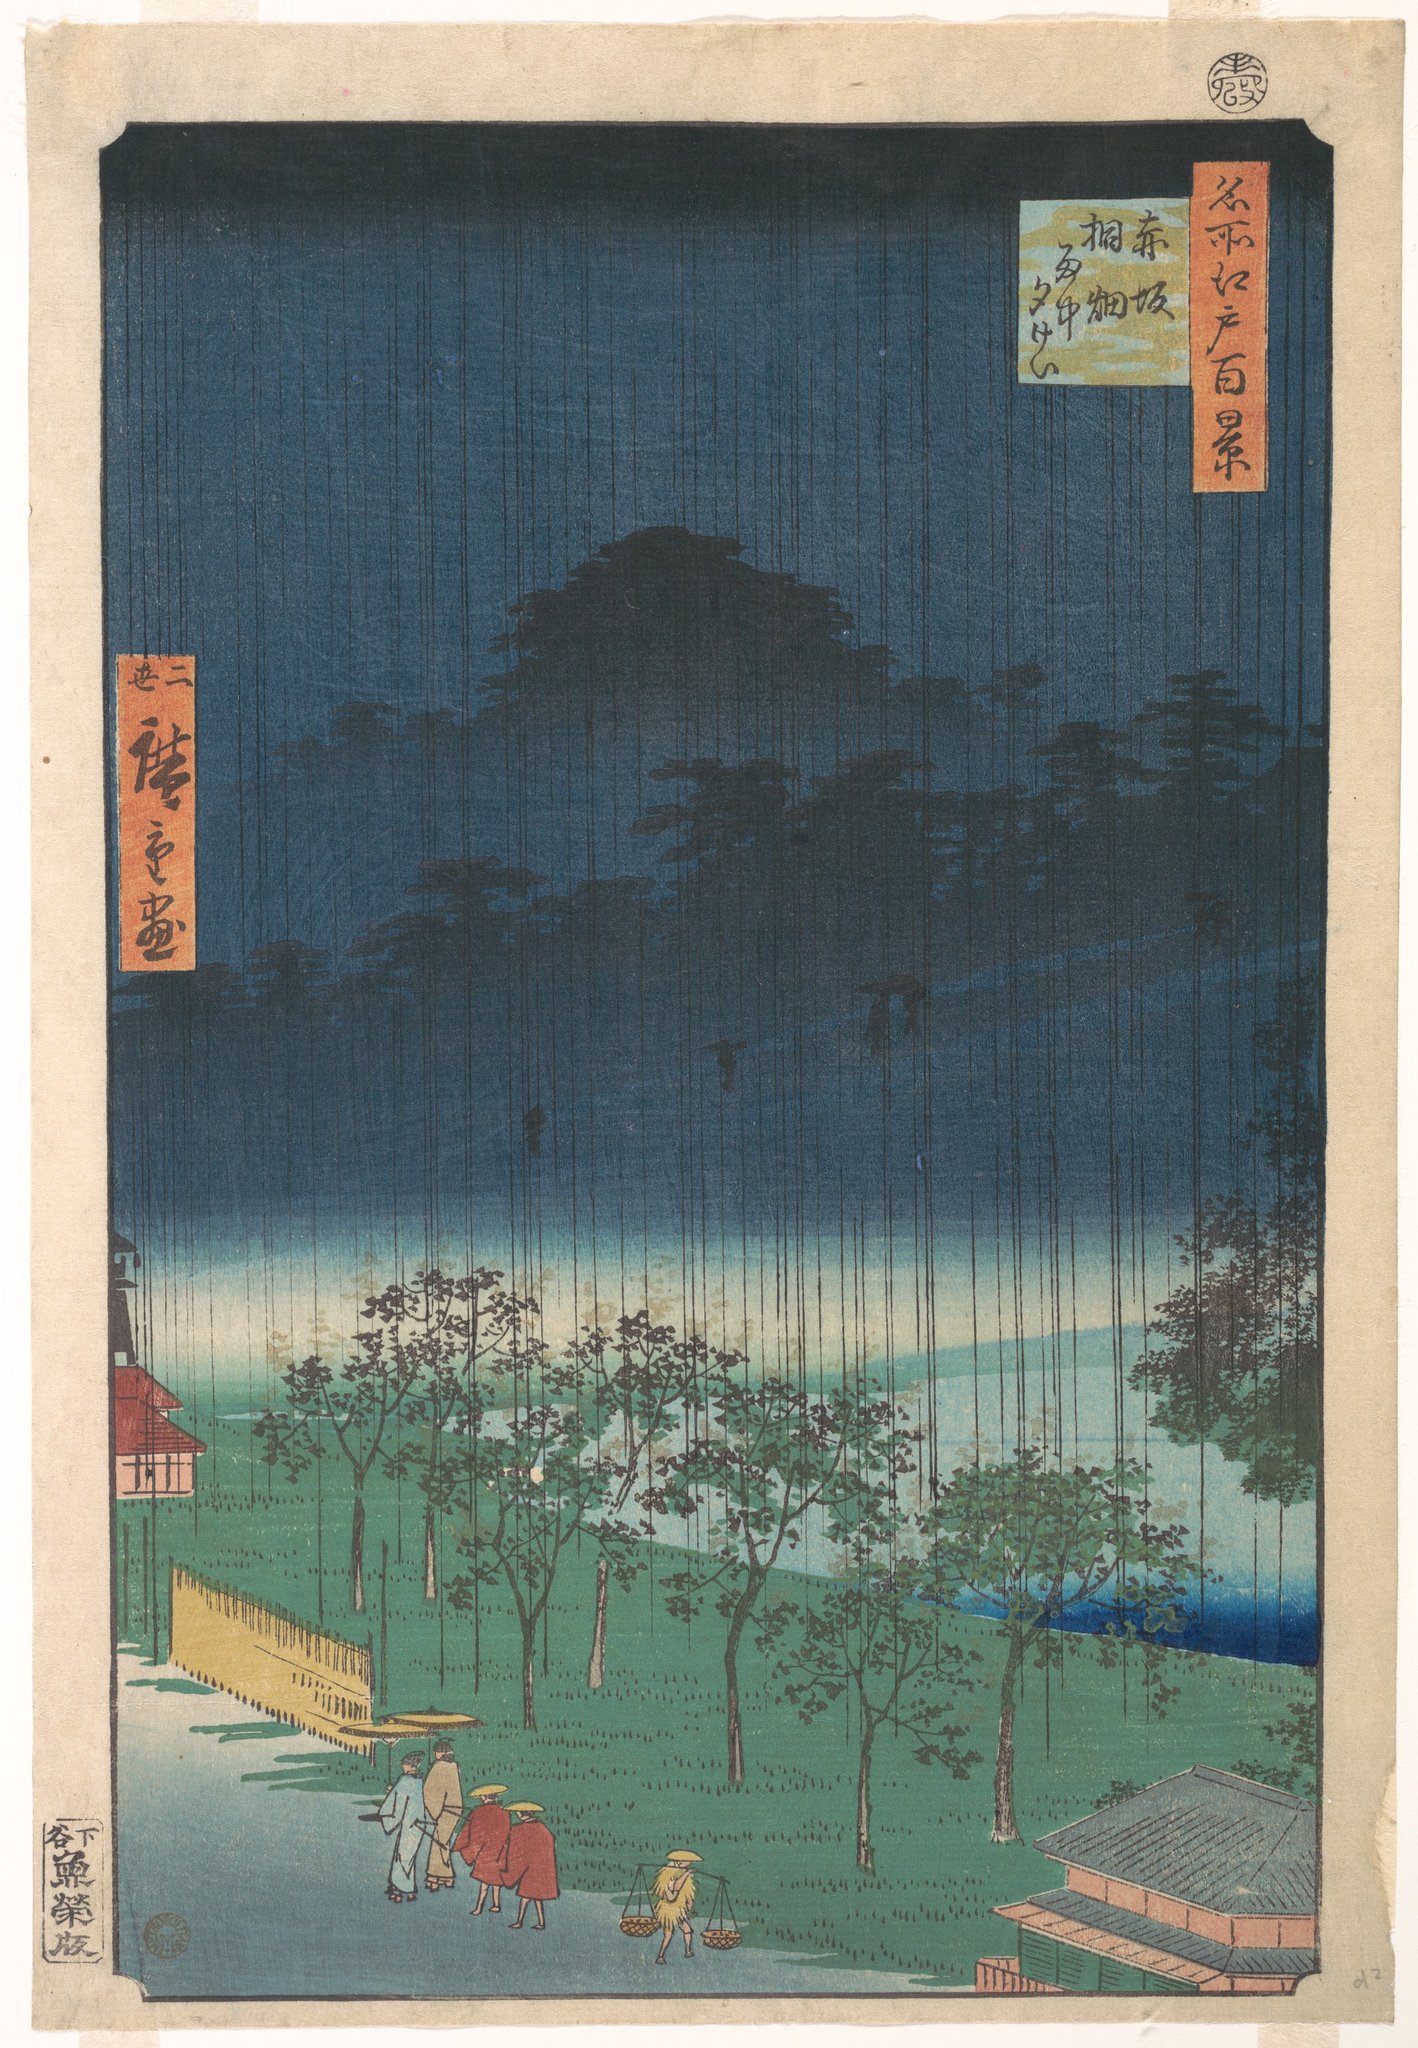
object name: print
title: Paulownia Trees at Akasaka in the Evening Rain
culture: japanese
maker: utagawa hiroshige ii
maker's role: artist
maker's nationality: japanese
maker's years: 1826-1869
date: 1859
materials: ink, paper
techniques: woodblock print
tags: human figures,trees,evening,rain